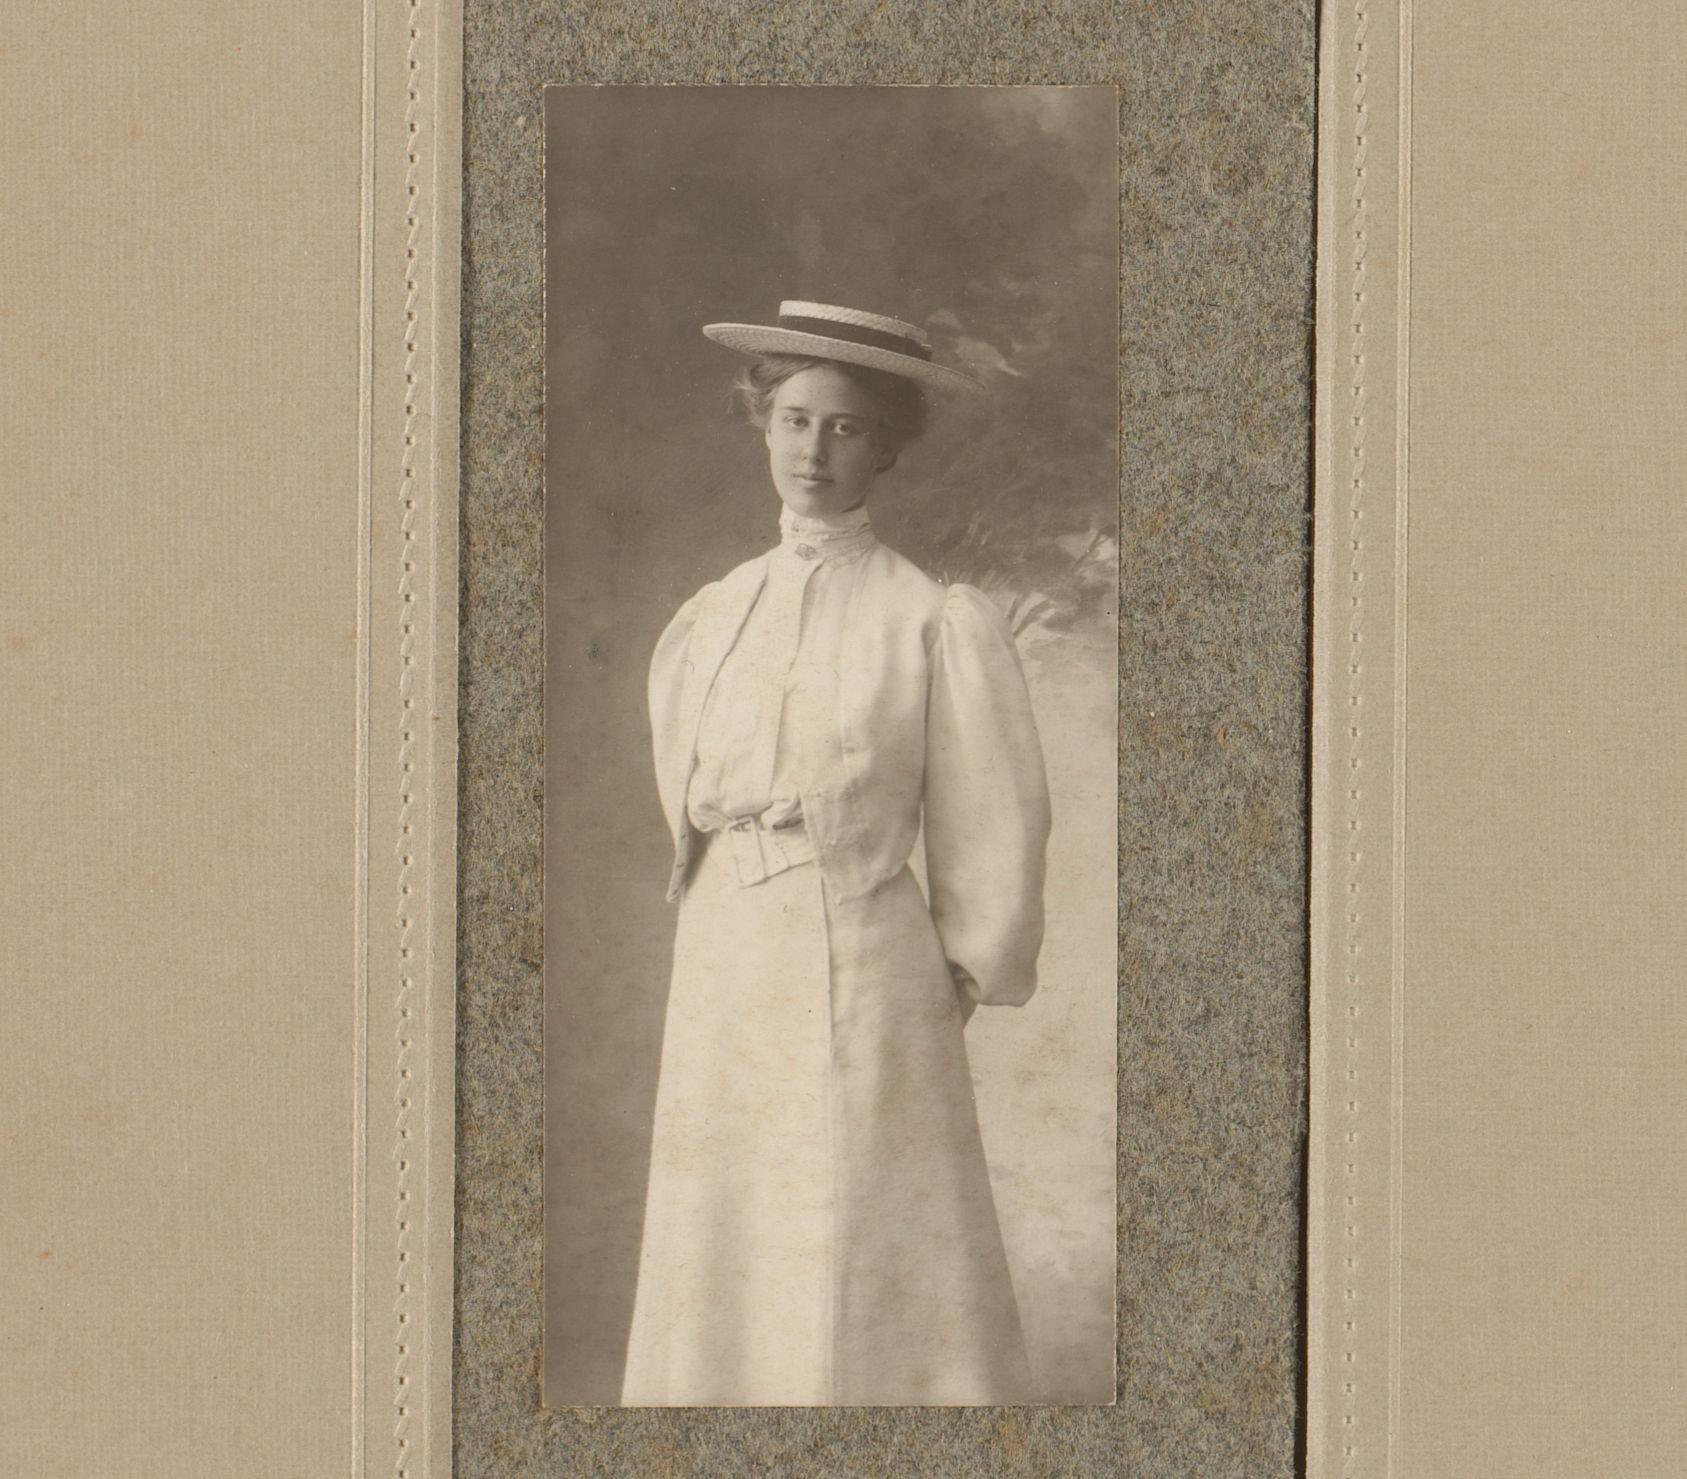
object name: photograph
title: Portret van een jonge vrouw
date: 1910-1920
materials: paper, photographic support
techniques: gelatin silver print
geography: netherlands